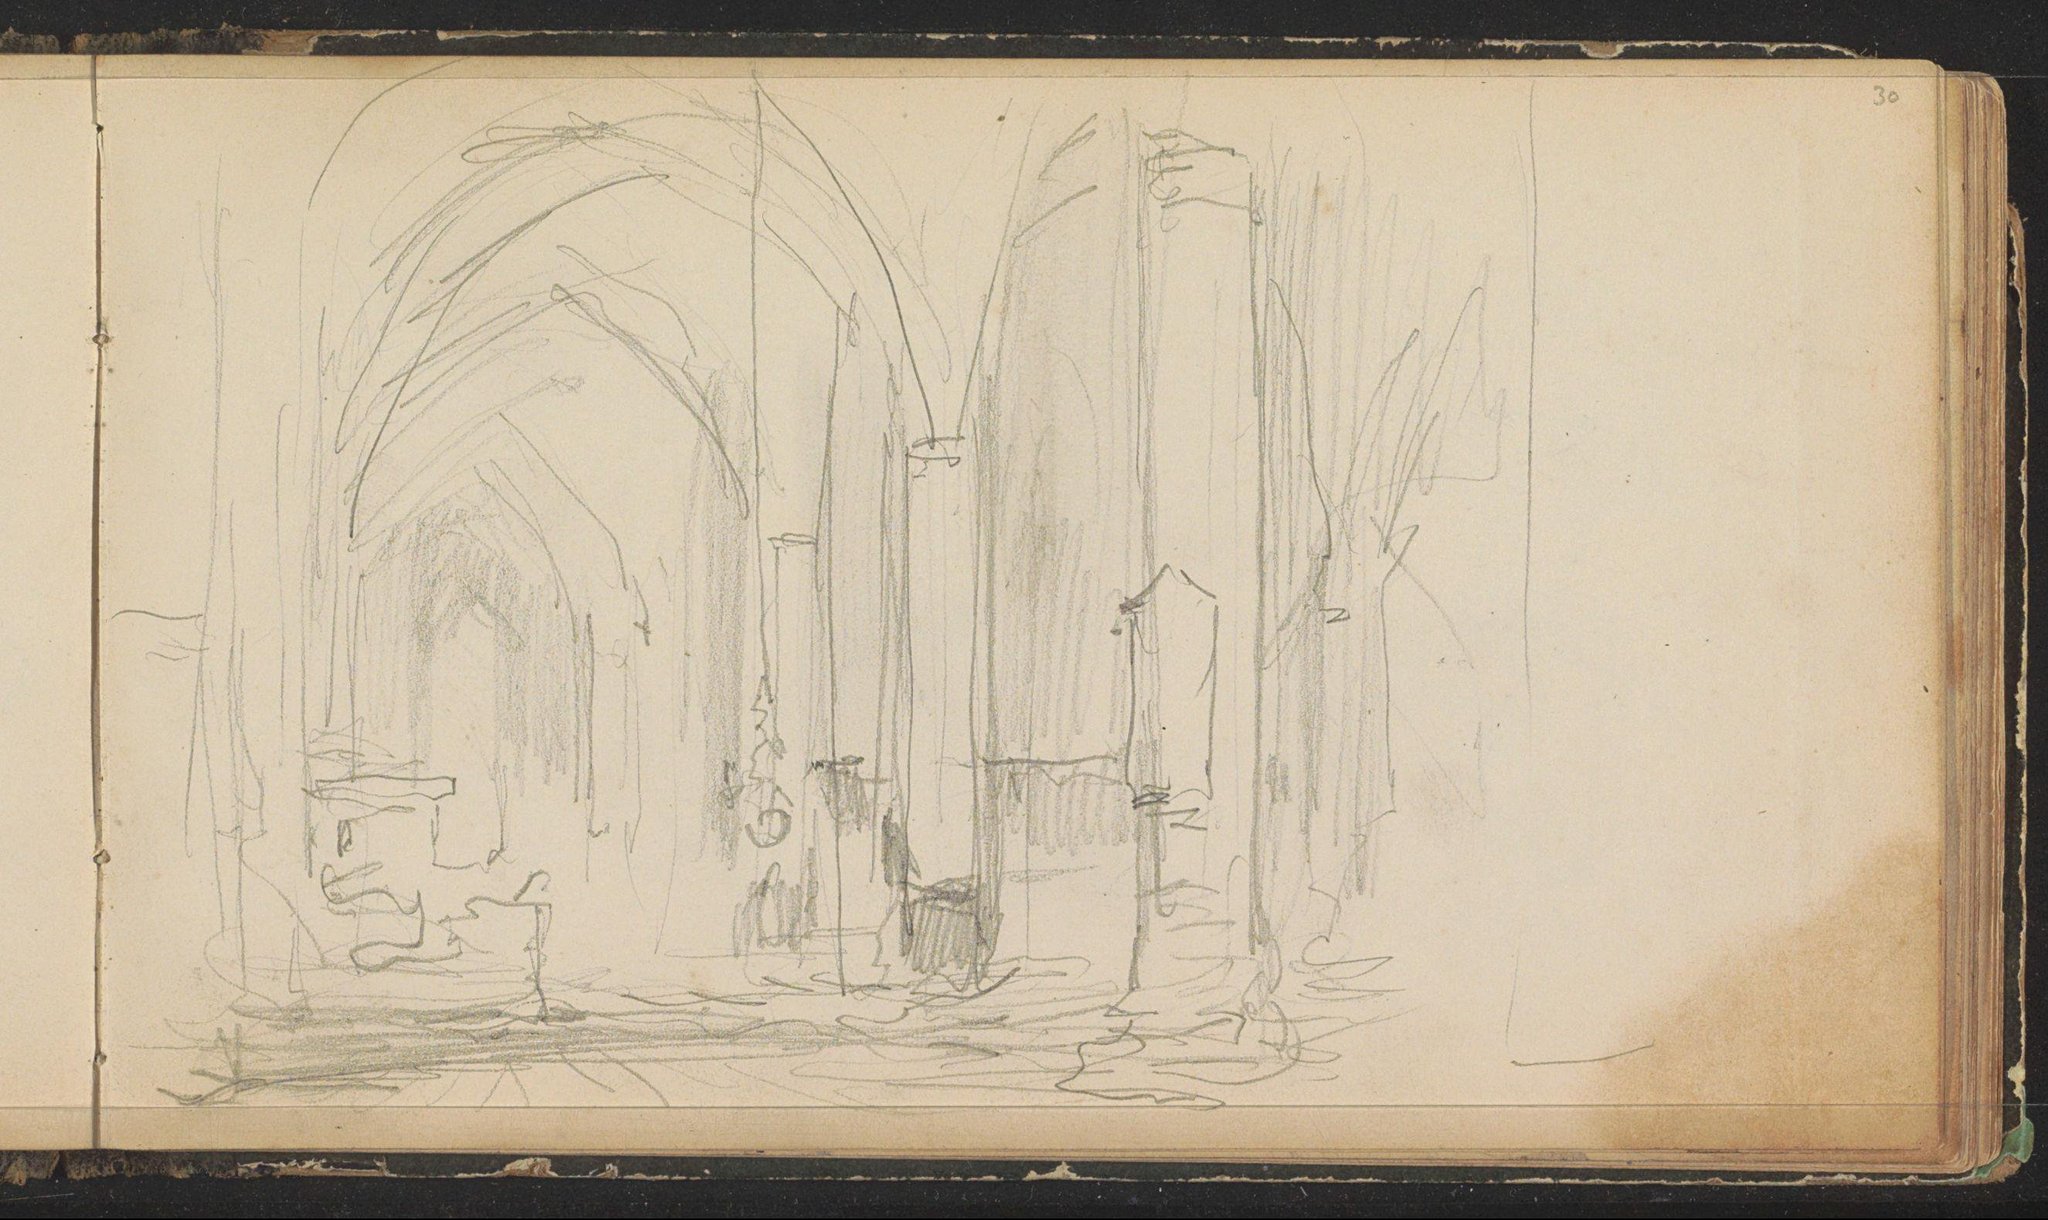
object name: sketchbook leaf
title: Kerkinterieur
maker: johannes bosboom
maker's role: draughtsman, painter, print maker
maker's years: 1817-1891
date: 1845-1891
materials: paper, pencil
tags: parts of church interior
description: Blad 30 recto uit een schetsboek met 46 bladen.